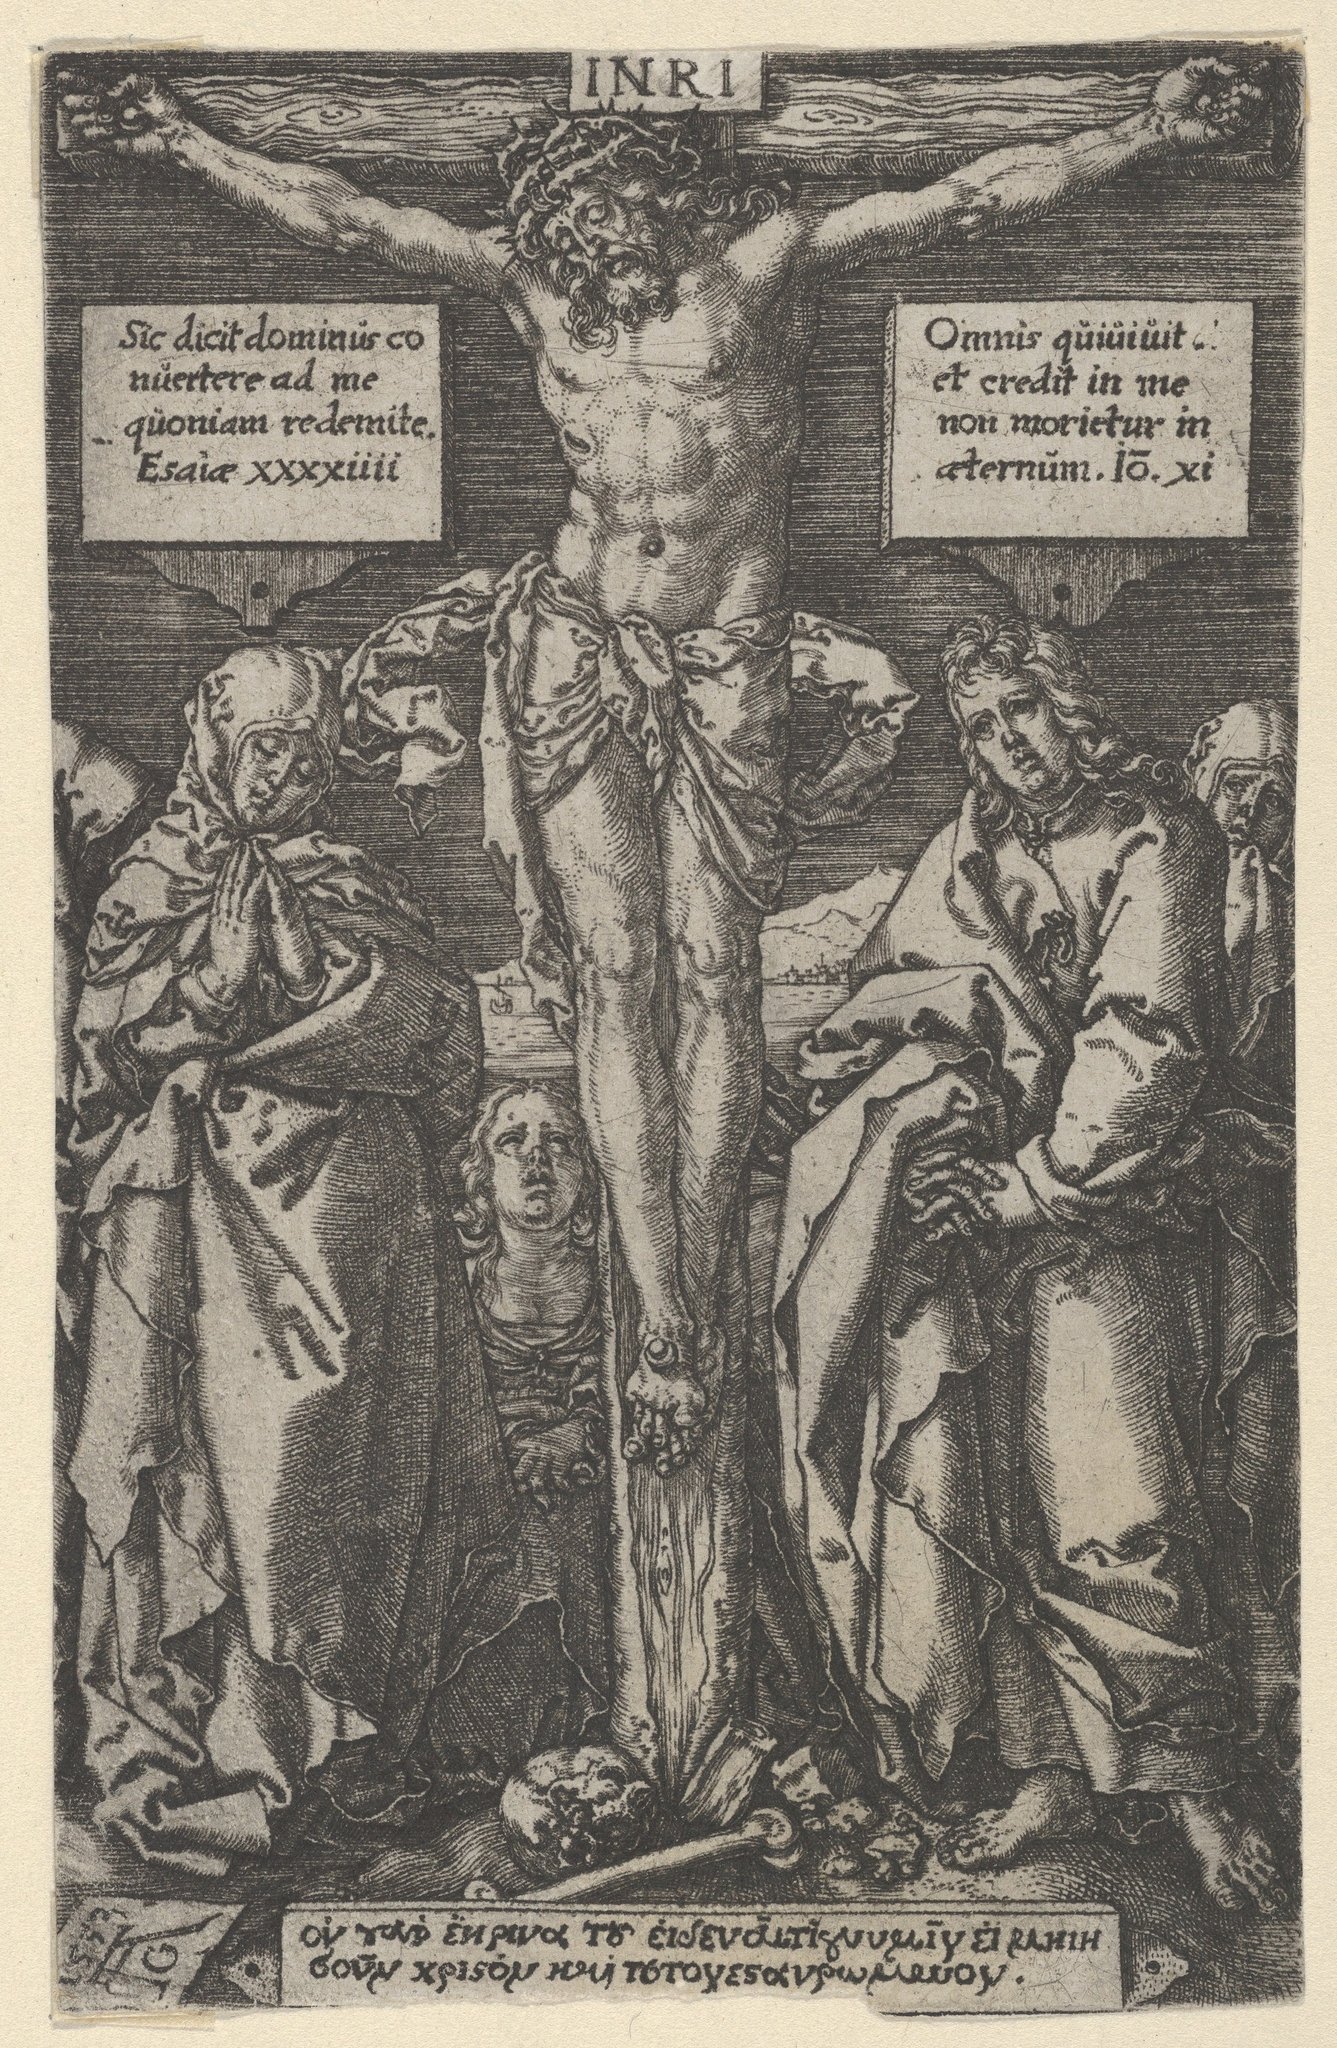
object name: print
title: Christ on the Cross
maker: heinrich aldegrever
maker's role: artist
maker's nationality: german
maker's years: 1502-1561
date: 1553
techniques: engraving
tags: christ,mary magdalene,saint john the baptist,virgin mary,cross